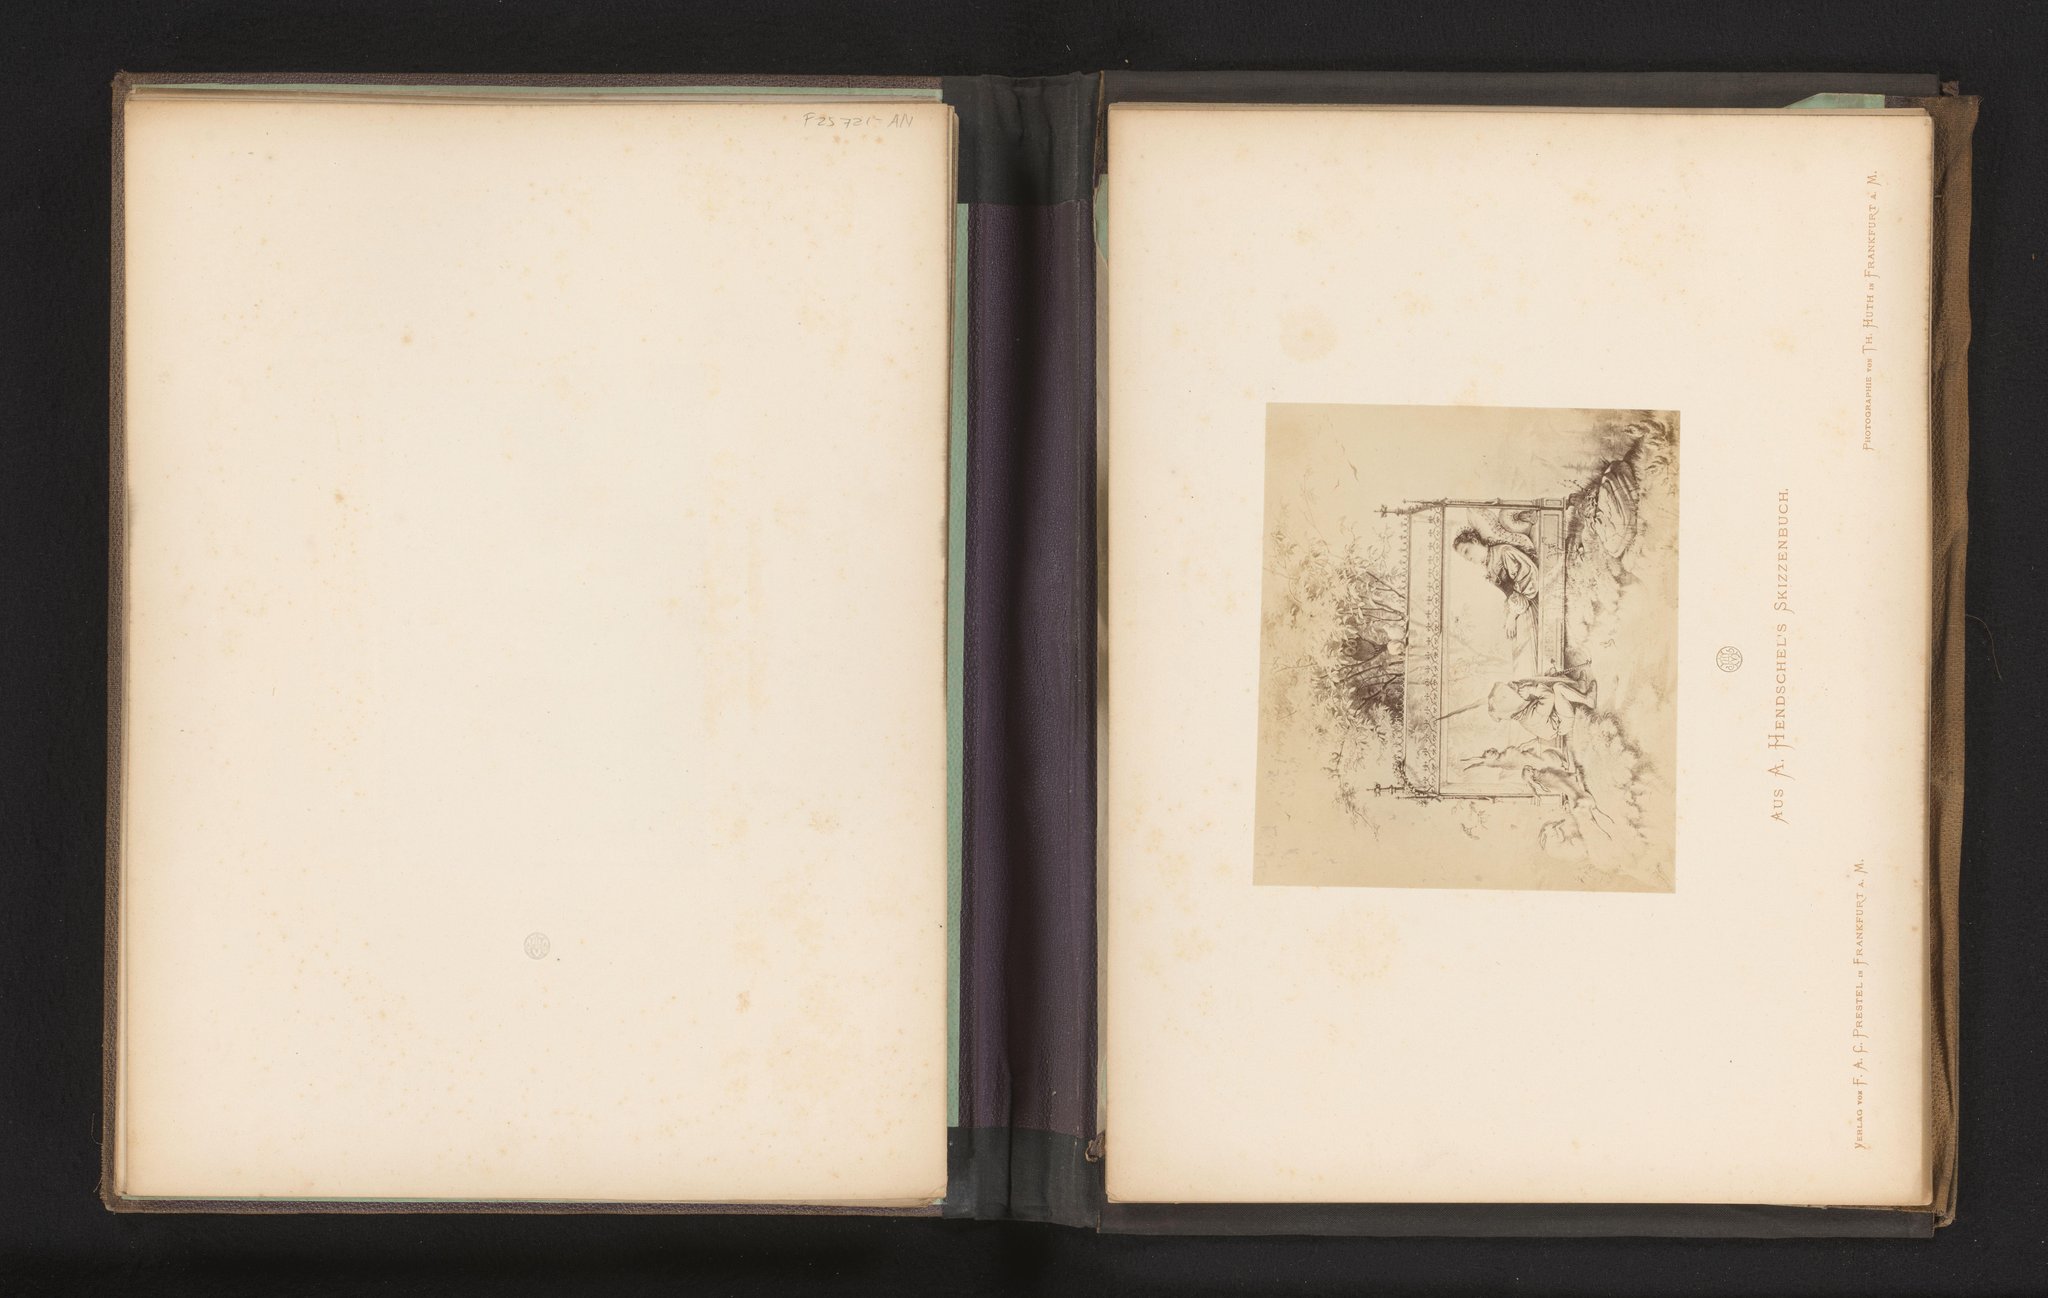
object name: photograph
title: Fotoreproductie van een schets van Sneeuwwitje op een bed door Albert Hendschel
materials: paper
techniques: albumen print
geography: frankfurt am main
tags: tales and fairy tales: sleeping beauty, sleeping in bed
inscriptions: monogram: ‘AH’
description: Deze foto maakt deel uit van een omslag met 50 foto's op 48 bladen, een lijst van afbeeldingen en een titelblad.